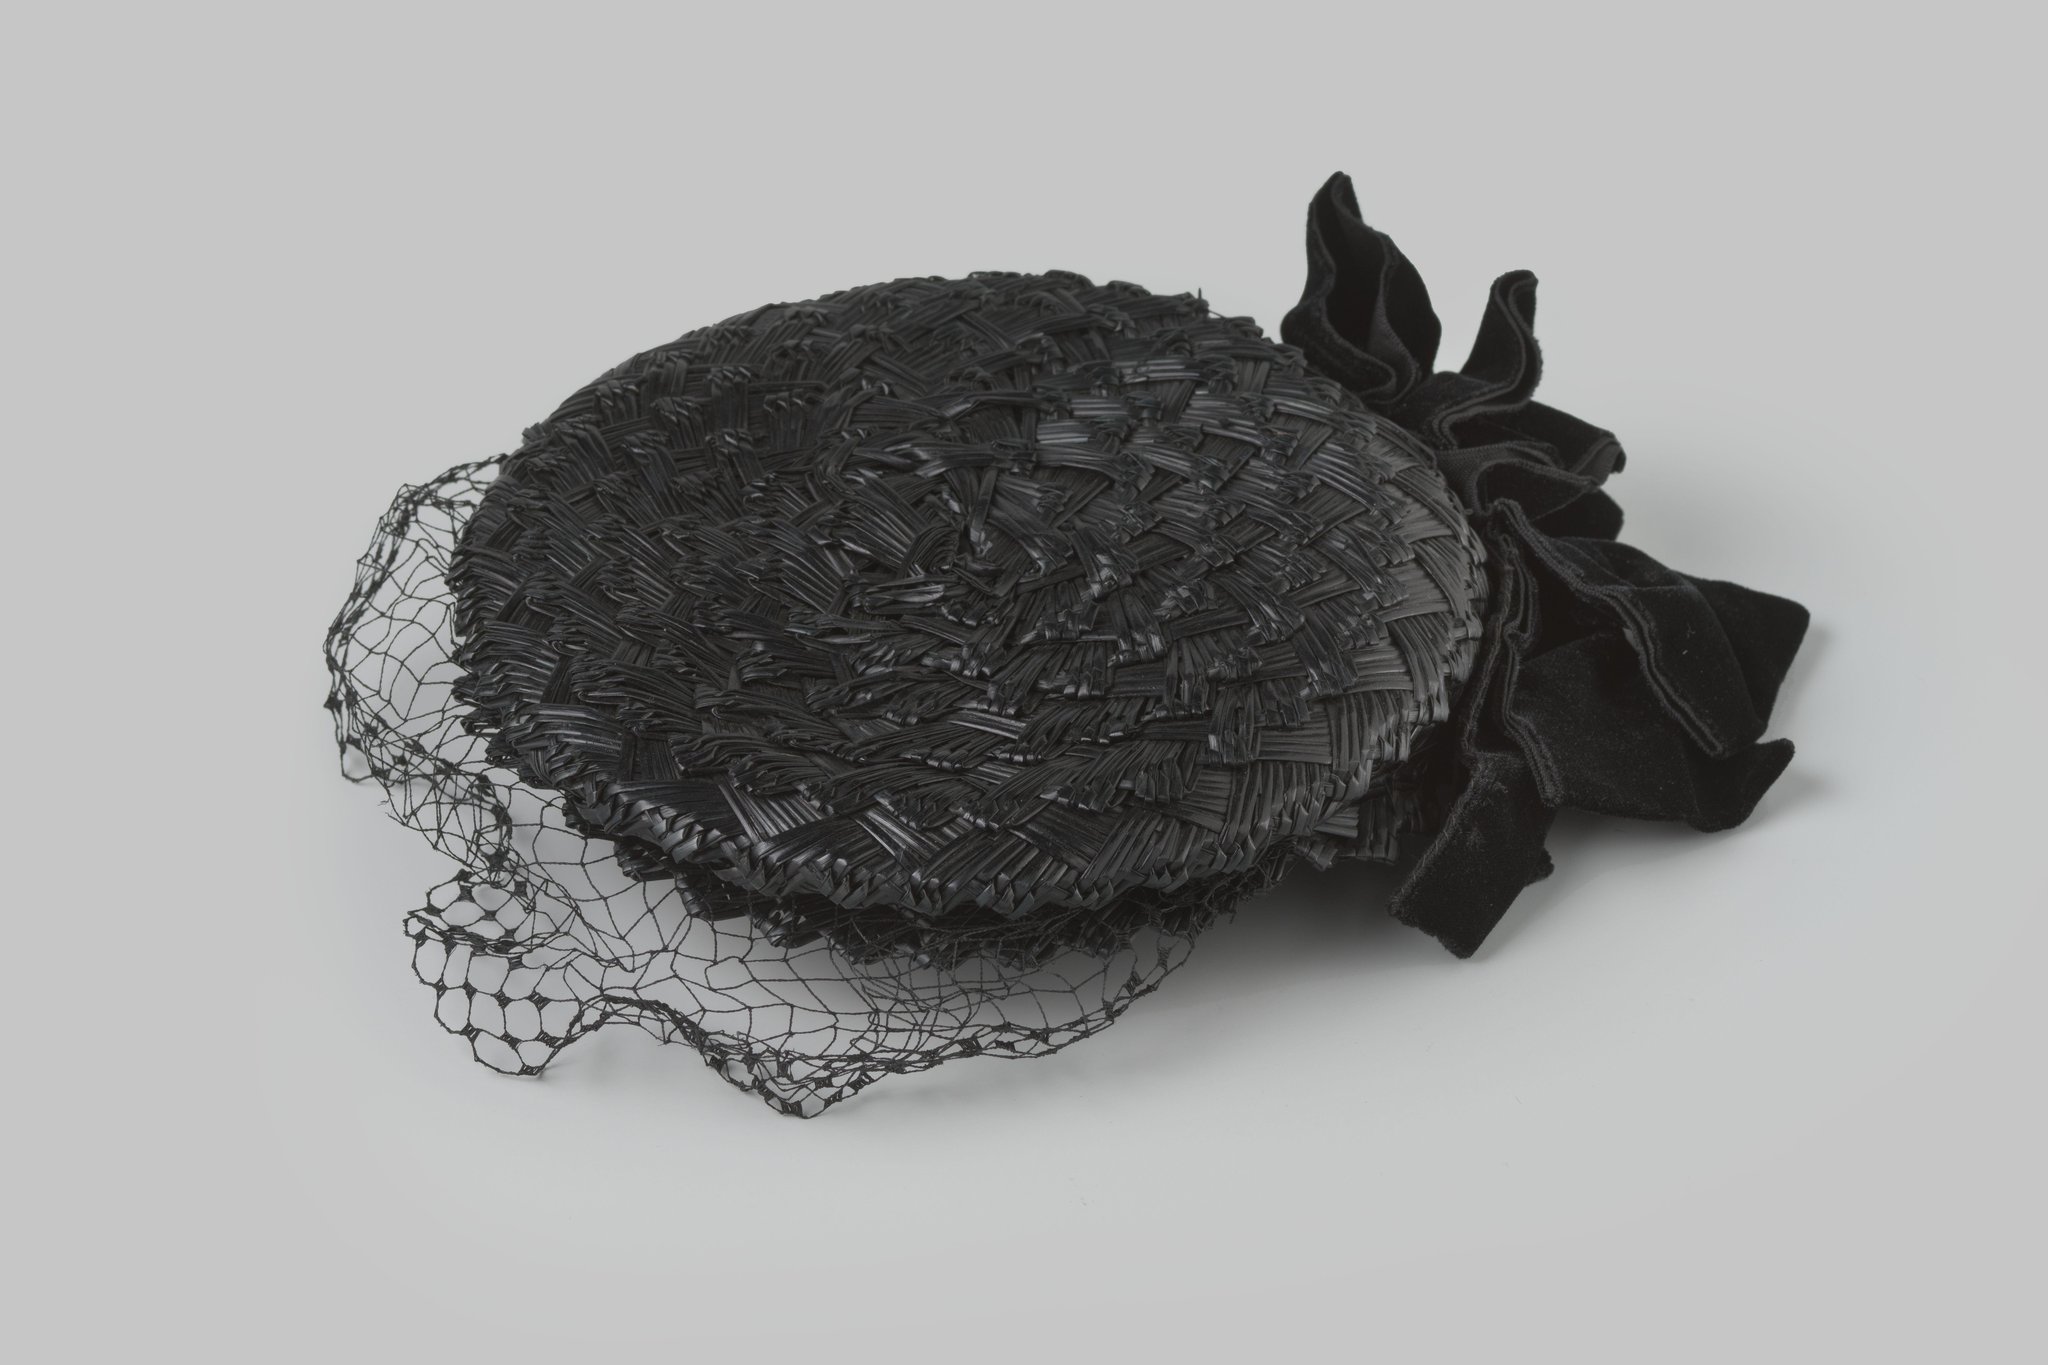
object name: hat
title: Hoed van grof zwart stro, met zwart fluwelen strik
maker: peter voorn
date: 1955-1957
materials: velvet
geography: amsterdam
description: Hoed van grof zwart stro, met zwart fluwelen strik. Zeer platte toque-tambourin, van achter iets brede, staande rand. Versiering van een strik met zes lussen en een klein zwart voiltje aan de voorkant. Adres: Peter Voorn/AMSTERDAM-Z.